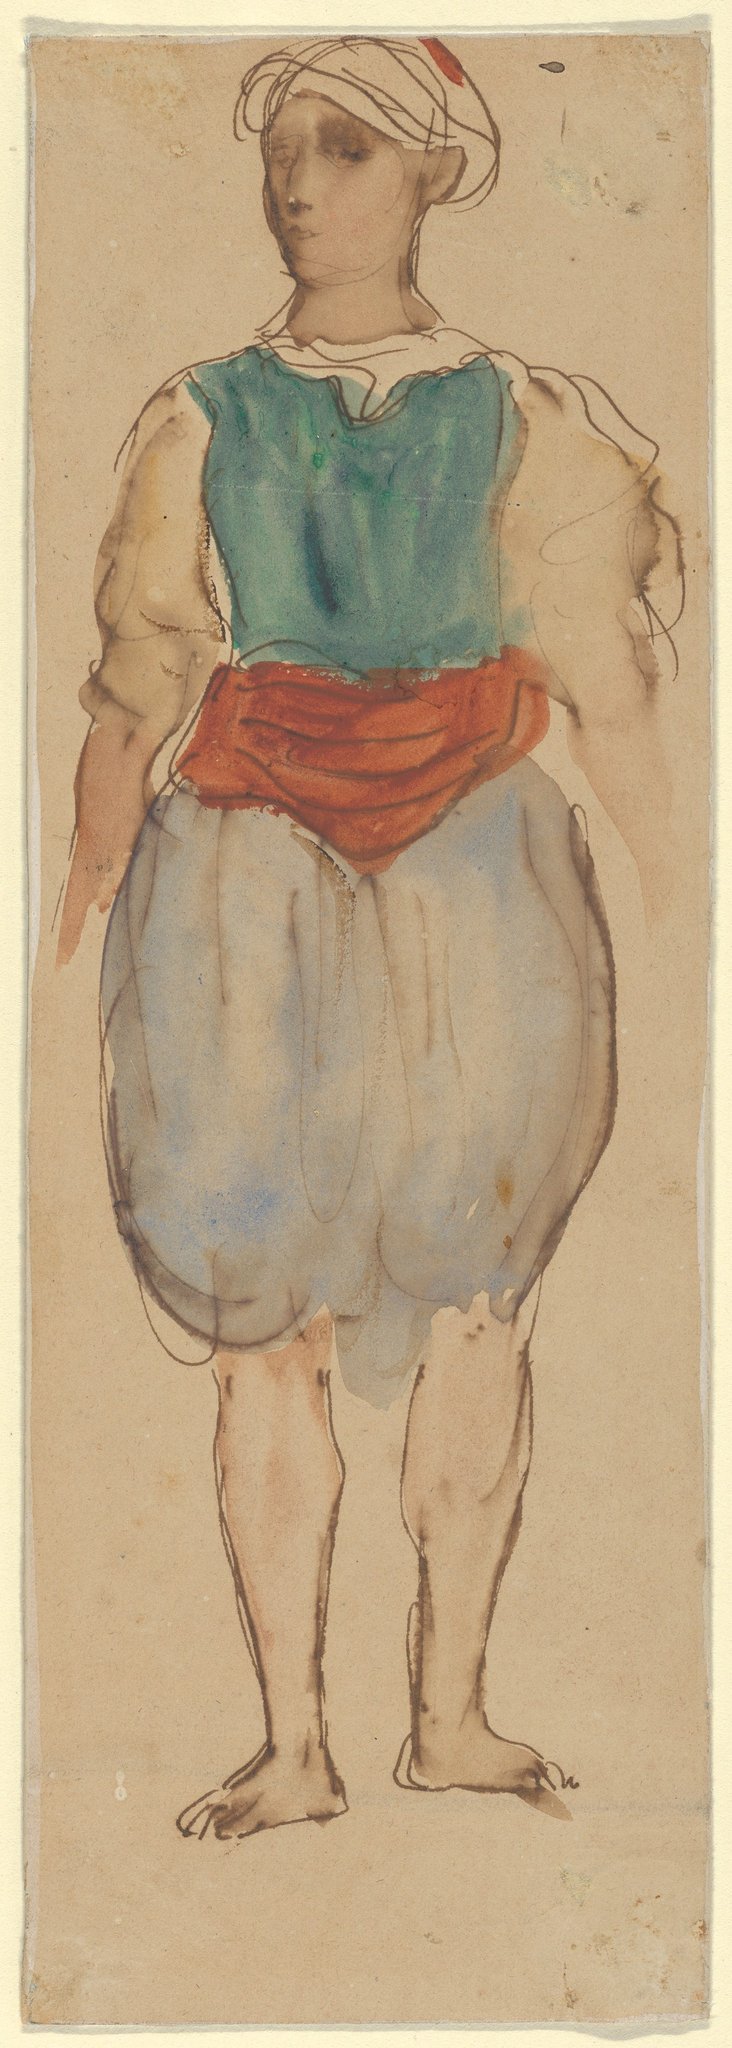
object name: drawing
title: Young Moroccan, Standing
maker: eugène delacroix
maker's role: artist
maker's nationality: french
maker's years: 1798-1863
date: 1832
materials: ink, watercolor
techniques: pen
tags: men